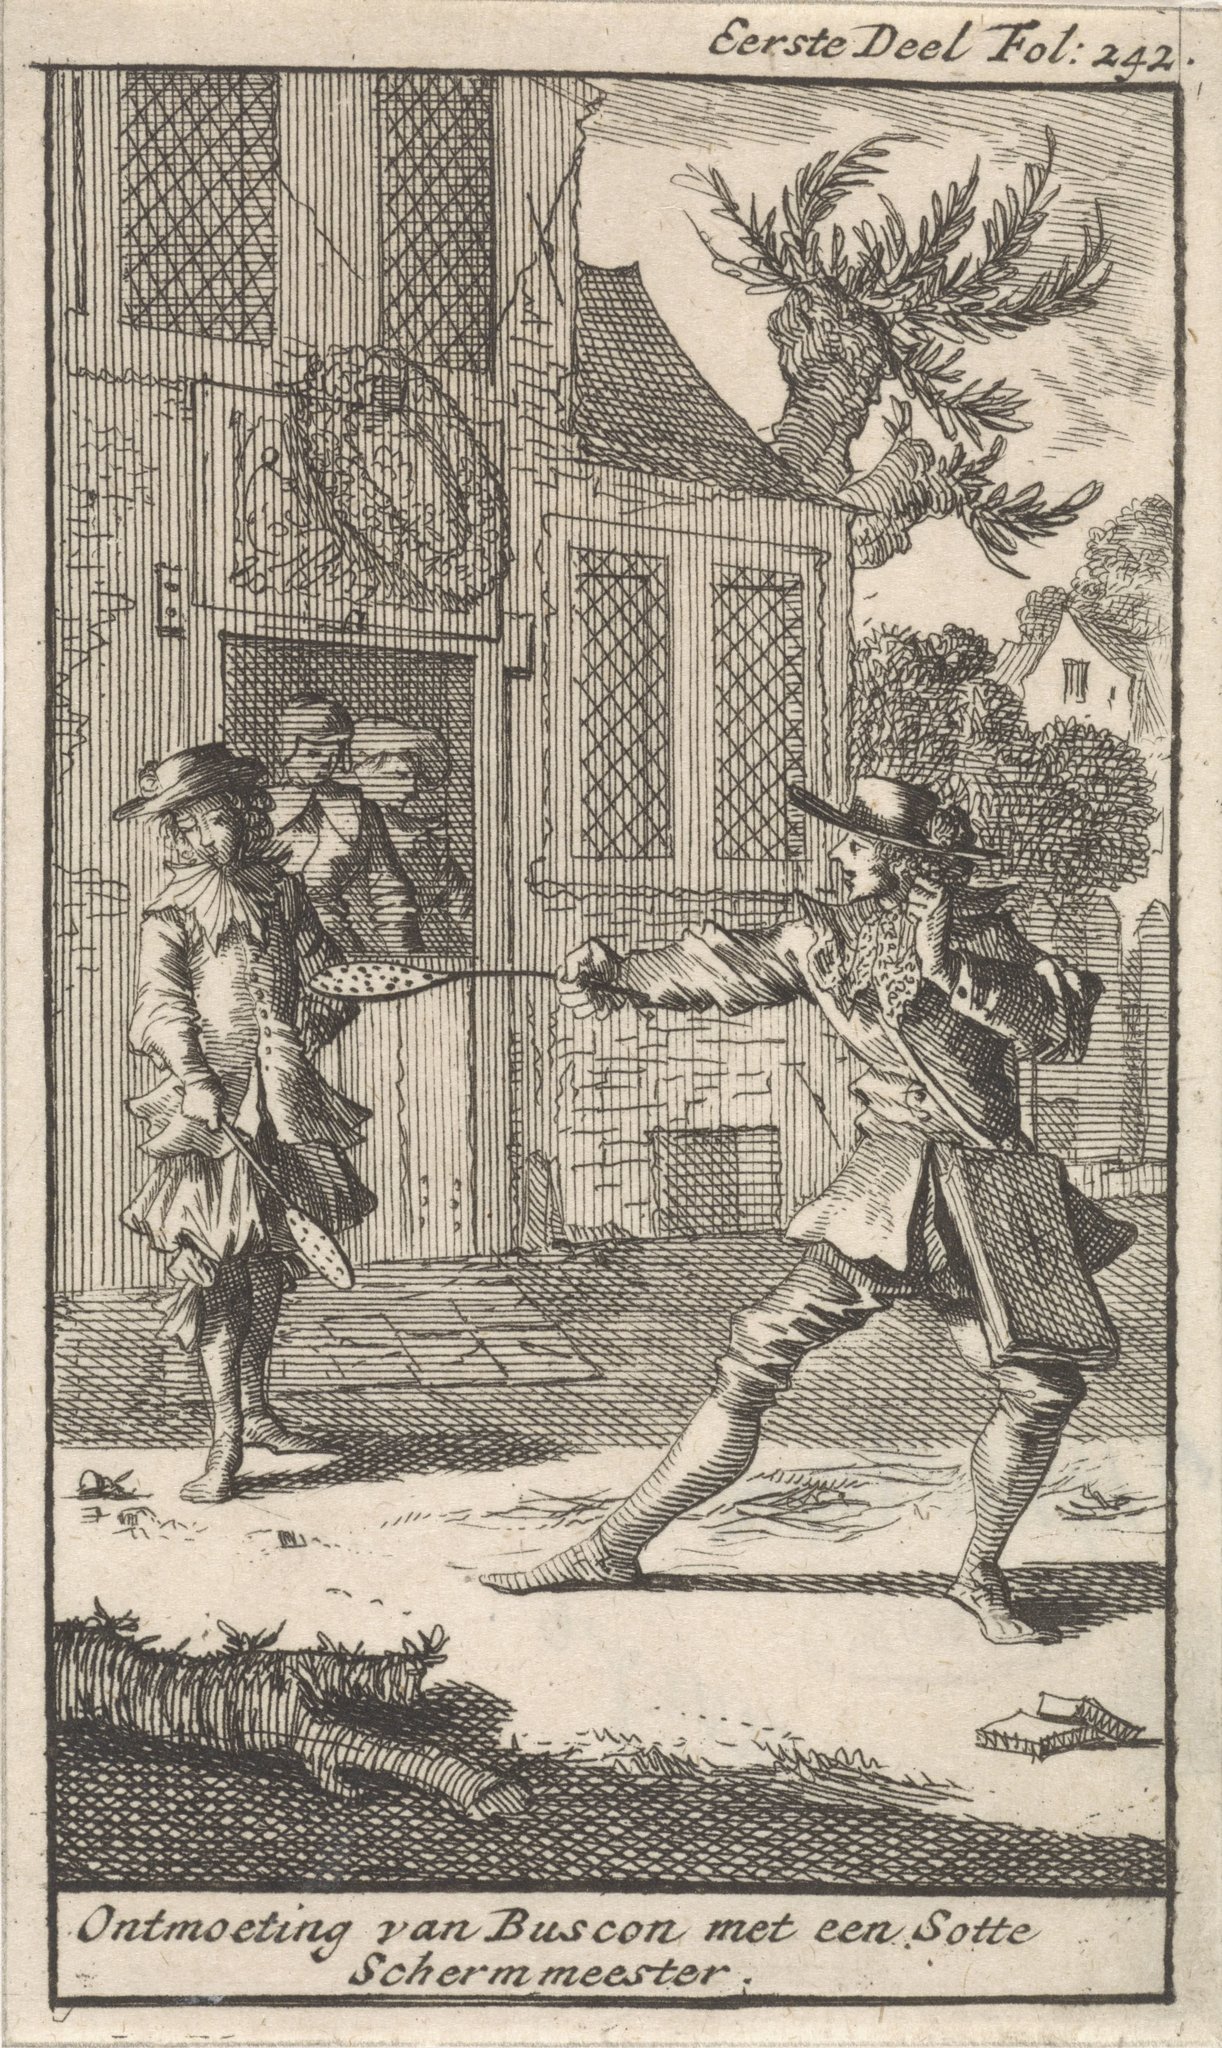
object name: book illustration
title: Ontmoeting van Buscon met een Sotte Schermmeester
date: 1699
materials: paper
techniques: etching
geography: amsterdam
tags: fencing (sport) (+ sportsman, player, etc.), inn, coffee-house, public house, etc., spoon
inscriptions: collector's mark: Lugt 2228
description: Bij een herberg ontmoet Don Pablo (Buscon) een krankzinnige schermmeester, die hem wilt leren schermen met een schuimspaan. Een scène uit het werk 'Historie van Buscon' van Francisco de Quevedo.